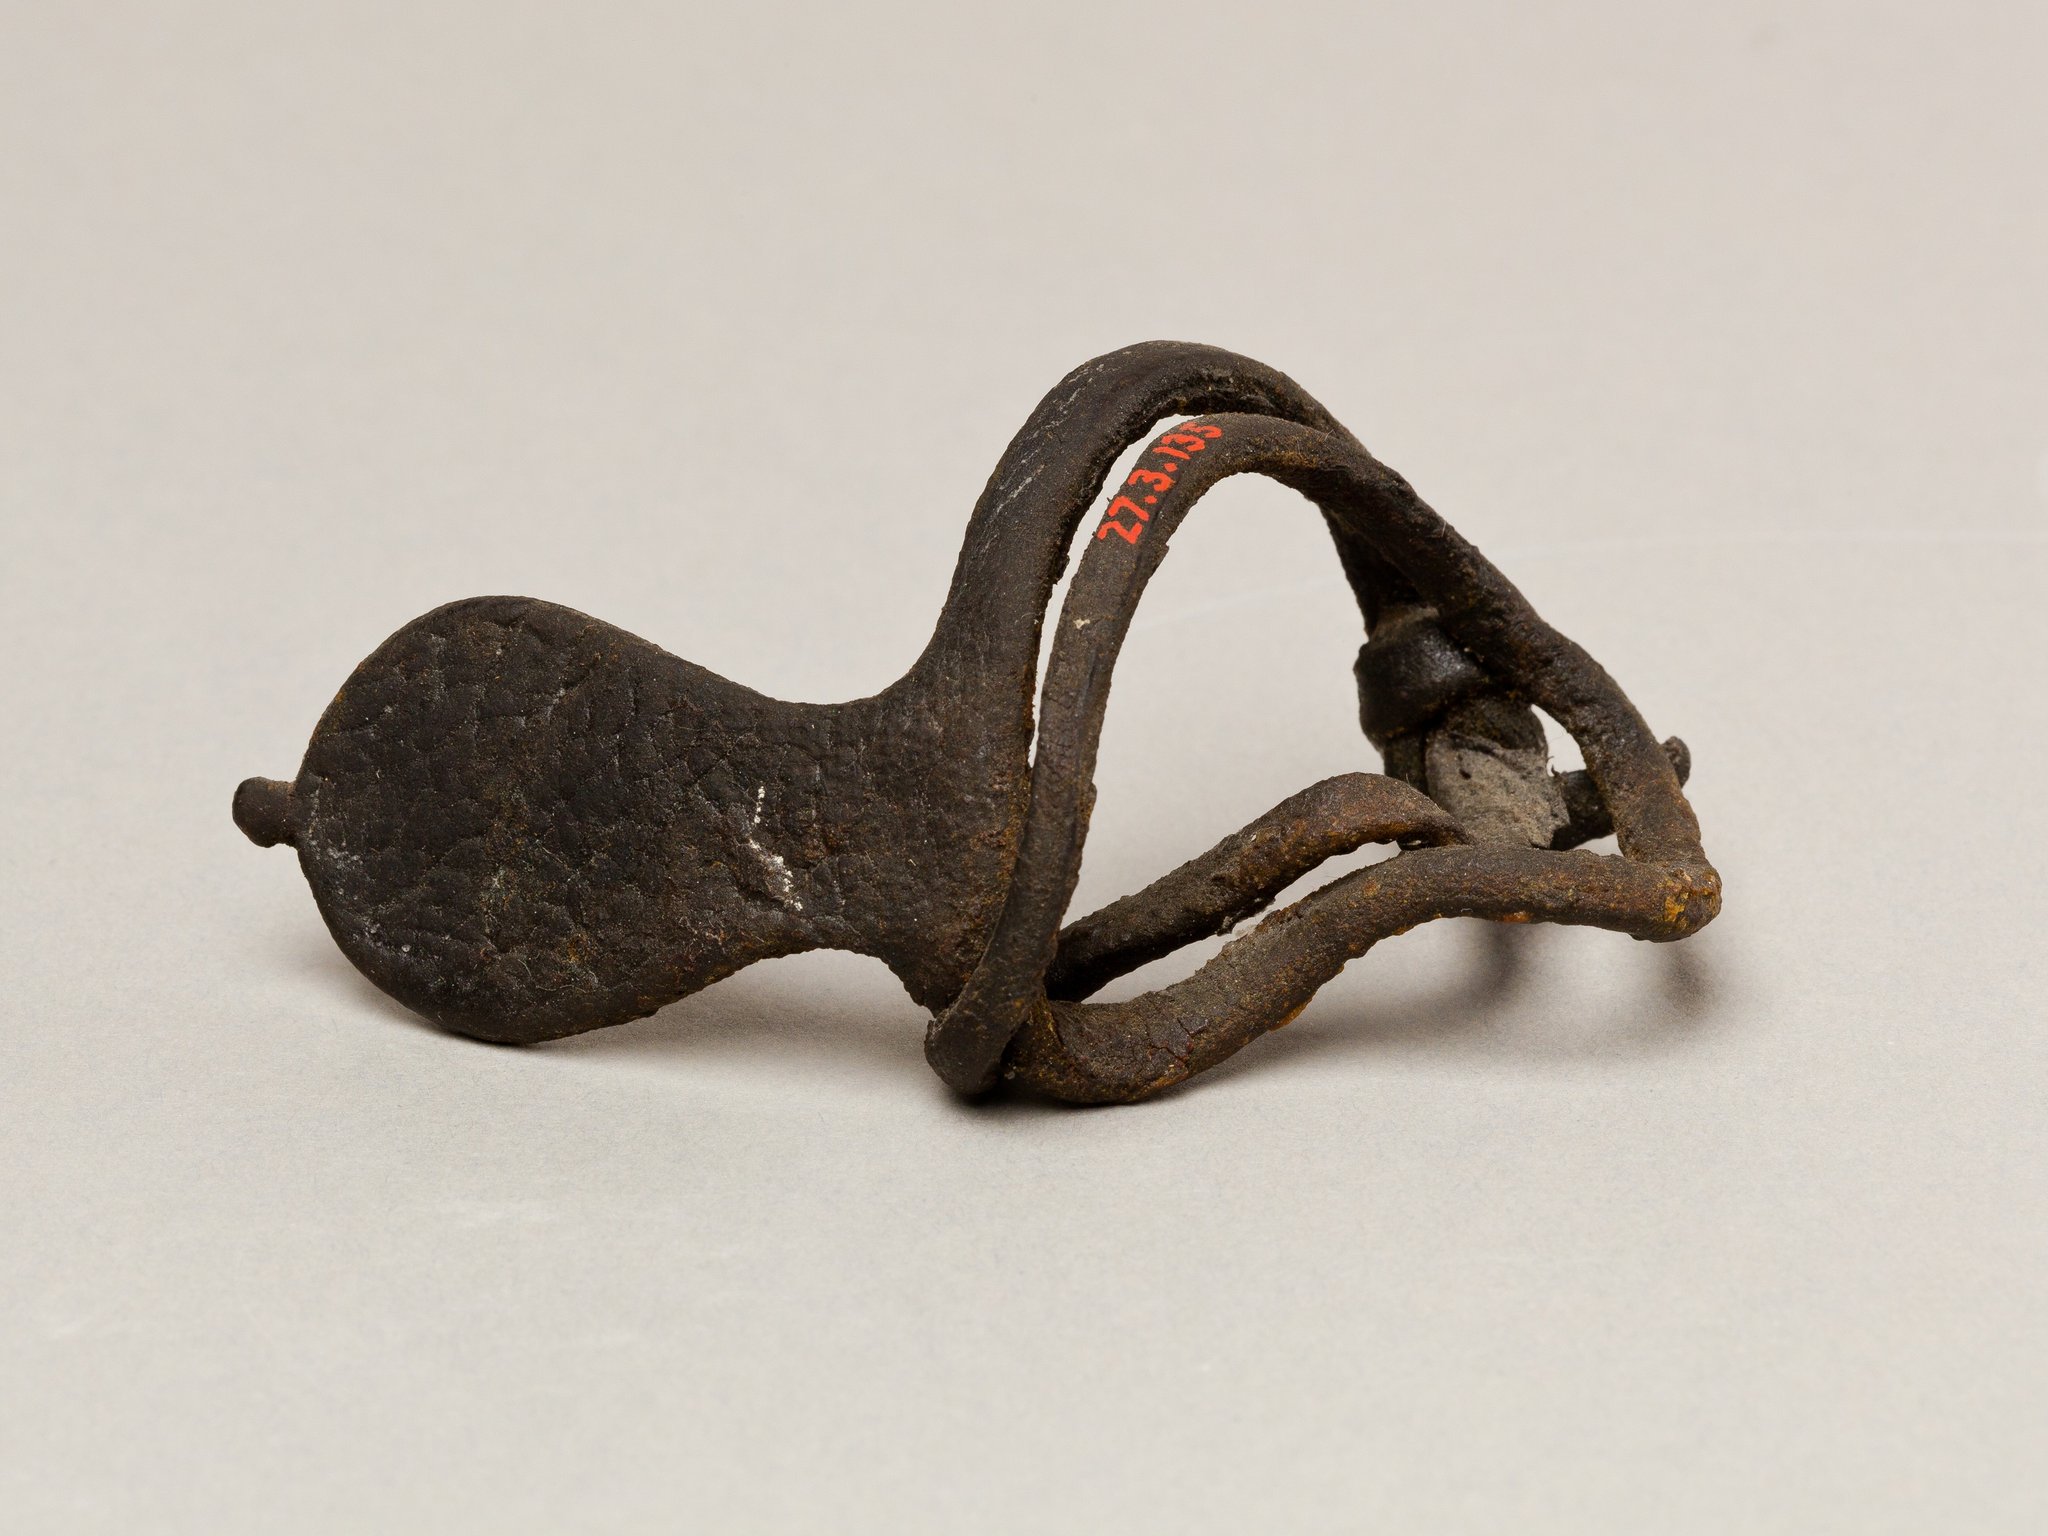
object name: archer's wrist guard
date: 1961-1917 BCE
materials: leather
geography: egypt